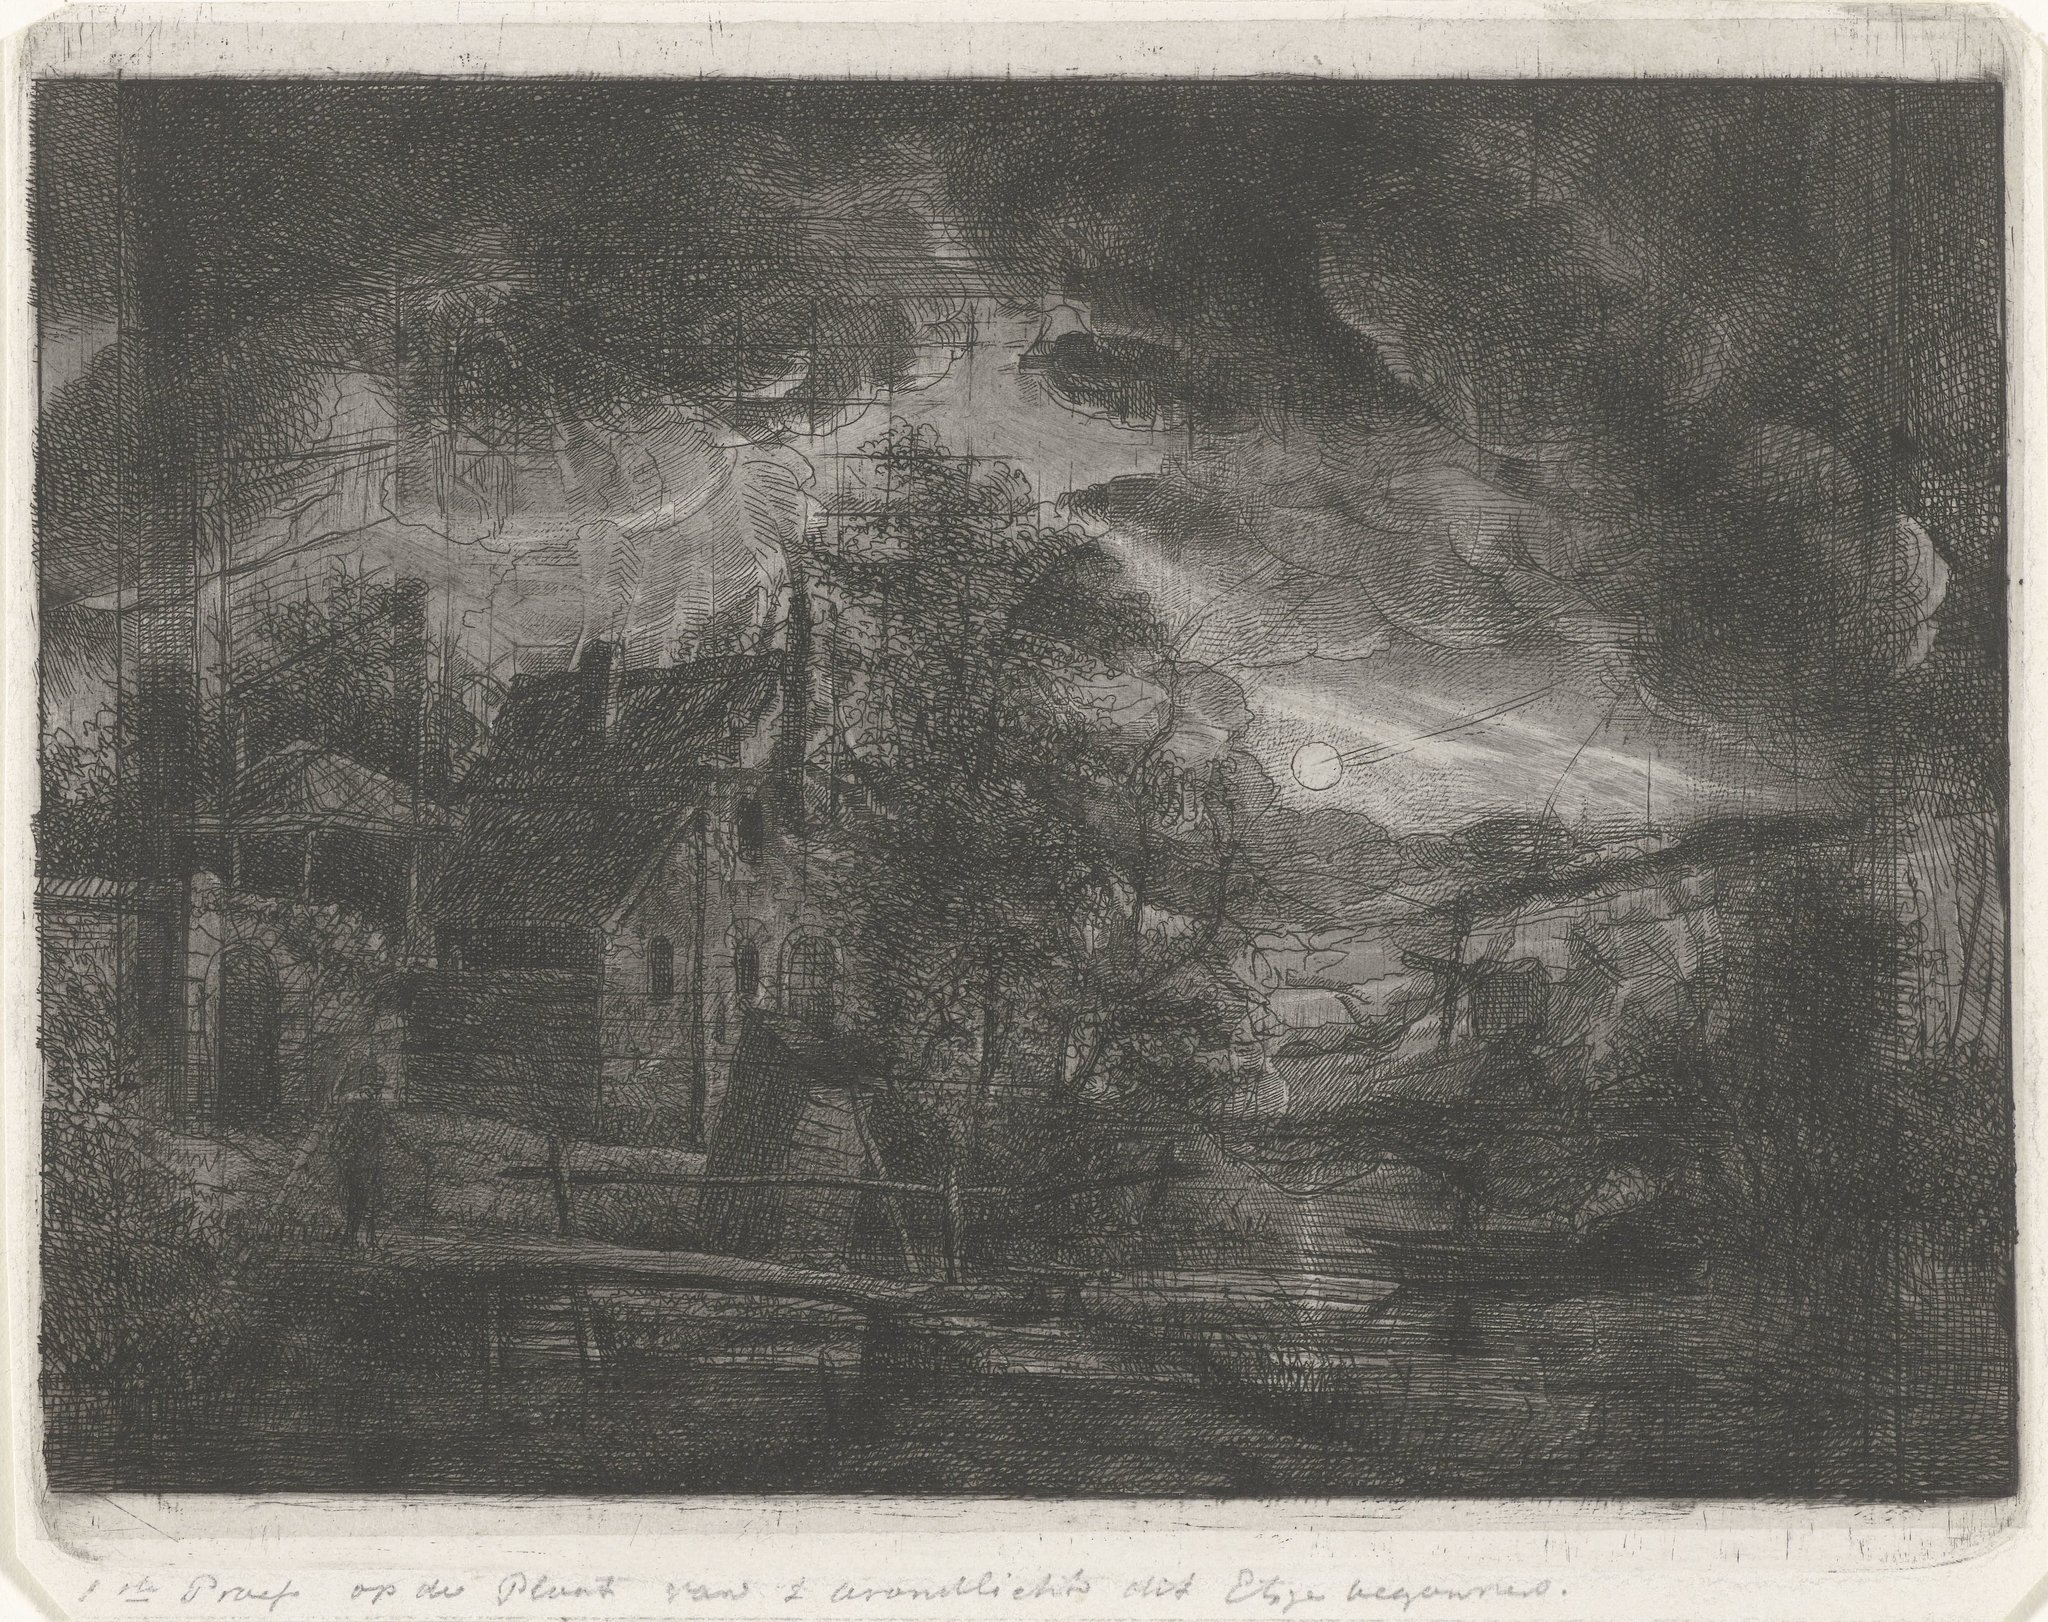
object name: print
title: Landschap bij maanlicht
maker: jacobus ludovicus cornet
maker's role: draughtsman, print maker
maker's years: 1815-1882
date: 1825-1882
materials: paper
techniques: etching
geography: leiden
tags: river bank, moonlight, farm or solitary house in landscape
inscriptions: collector's mark: Lugt 2228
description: Een landschap met een huis aan het water in avondlicht. Op de voorgrond een brugje. Op de achtergrond een molen. De maan verlicht het landschap.